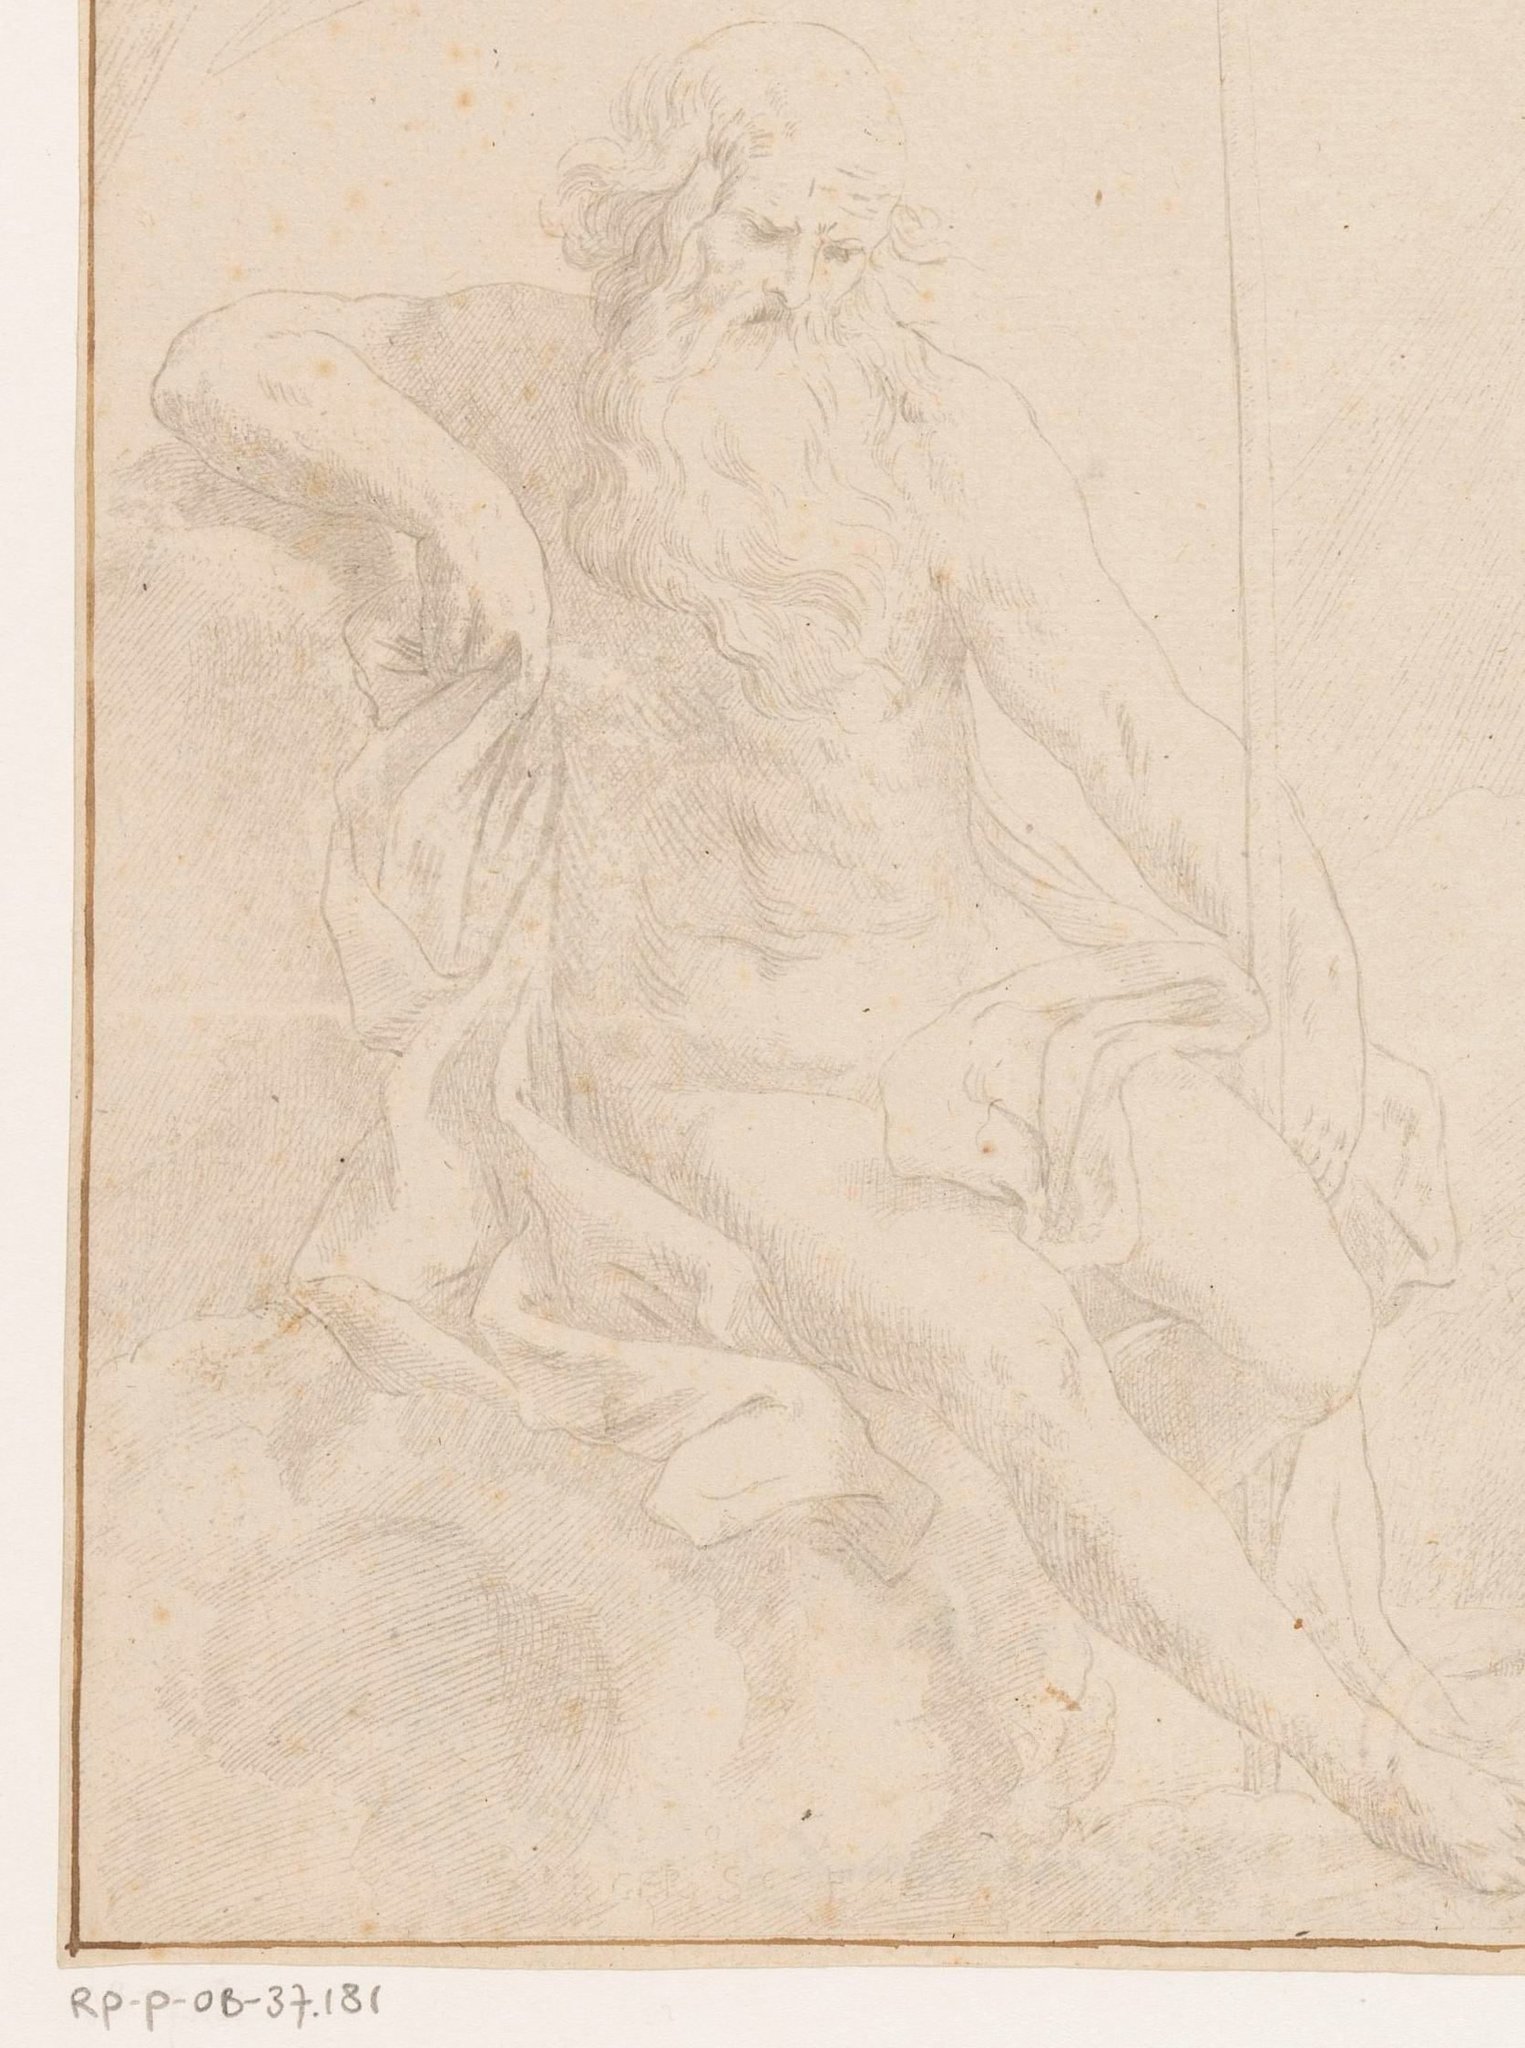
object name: print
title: Saturnus met zeis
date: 1620-1670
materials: ink, paper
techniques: printmaking, etching, pen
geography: italy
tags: (story of) saturn (cronus), attributes of saturn: scythe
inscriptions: inscription: ‘ofdruckzell van J.A. Sirano, constat, ii stuijver.’, collector's mark: Lugt 240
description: Saturnus met een zeis in de hand, zittend op een wolkenpartij.